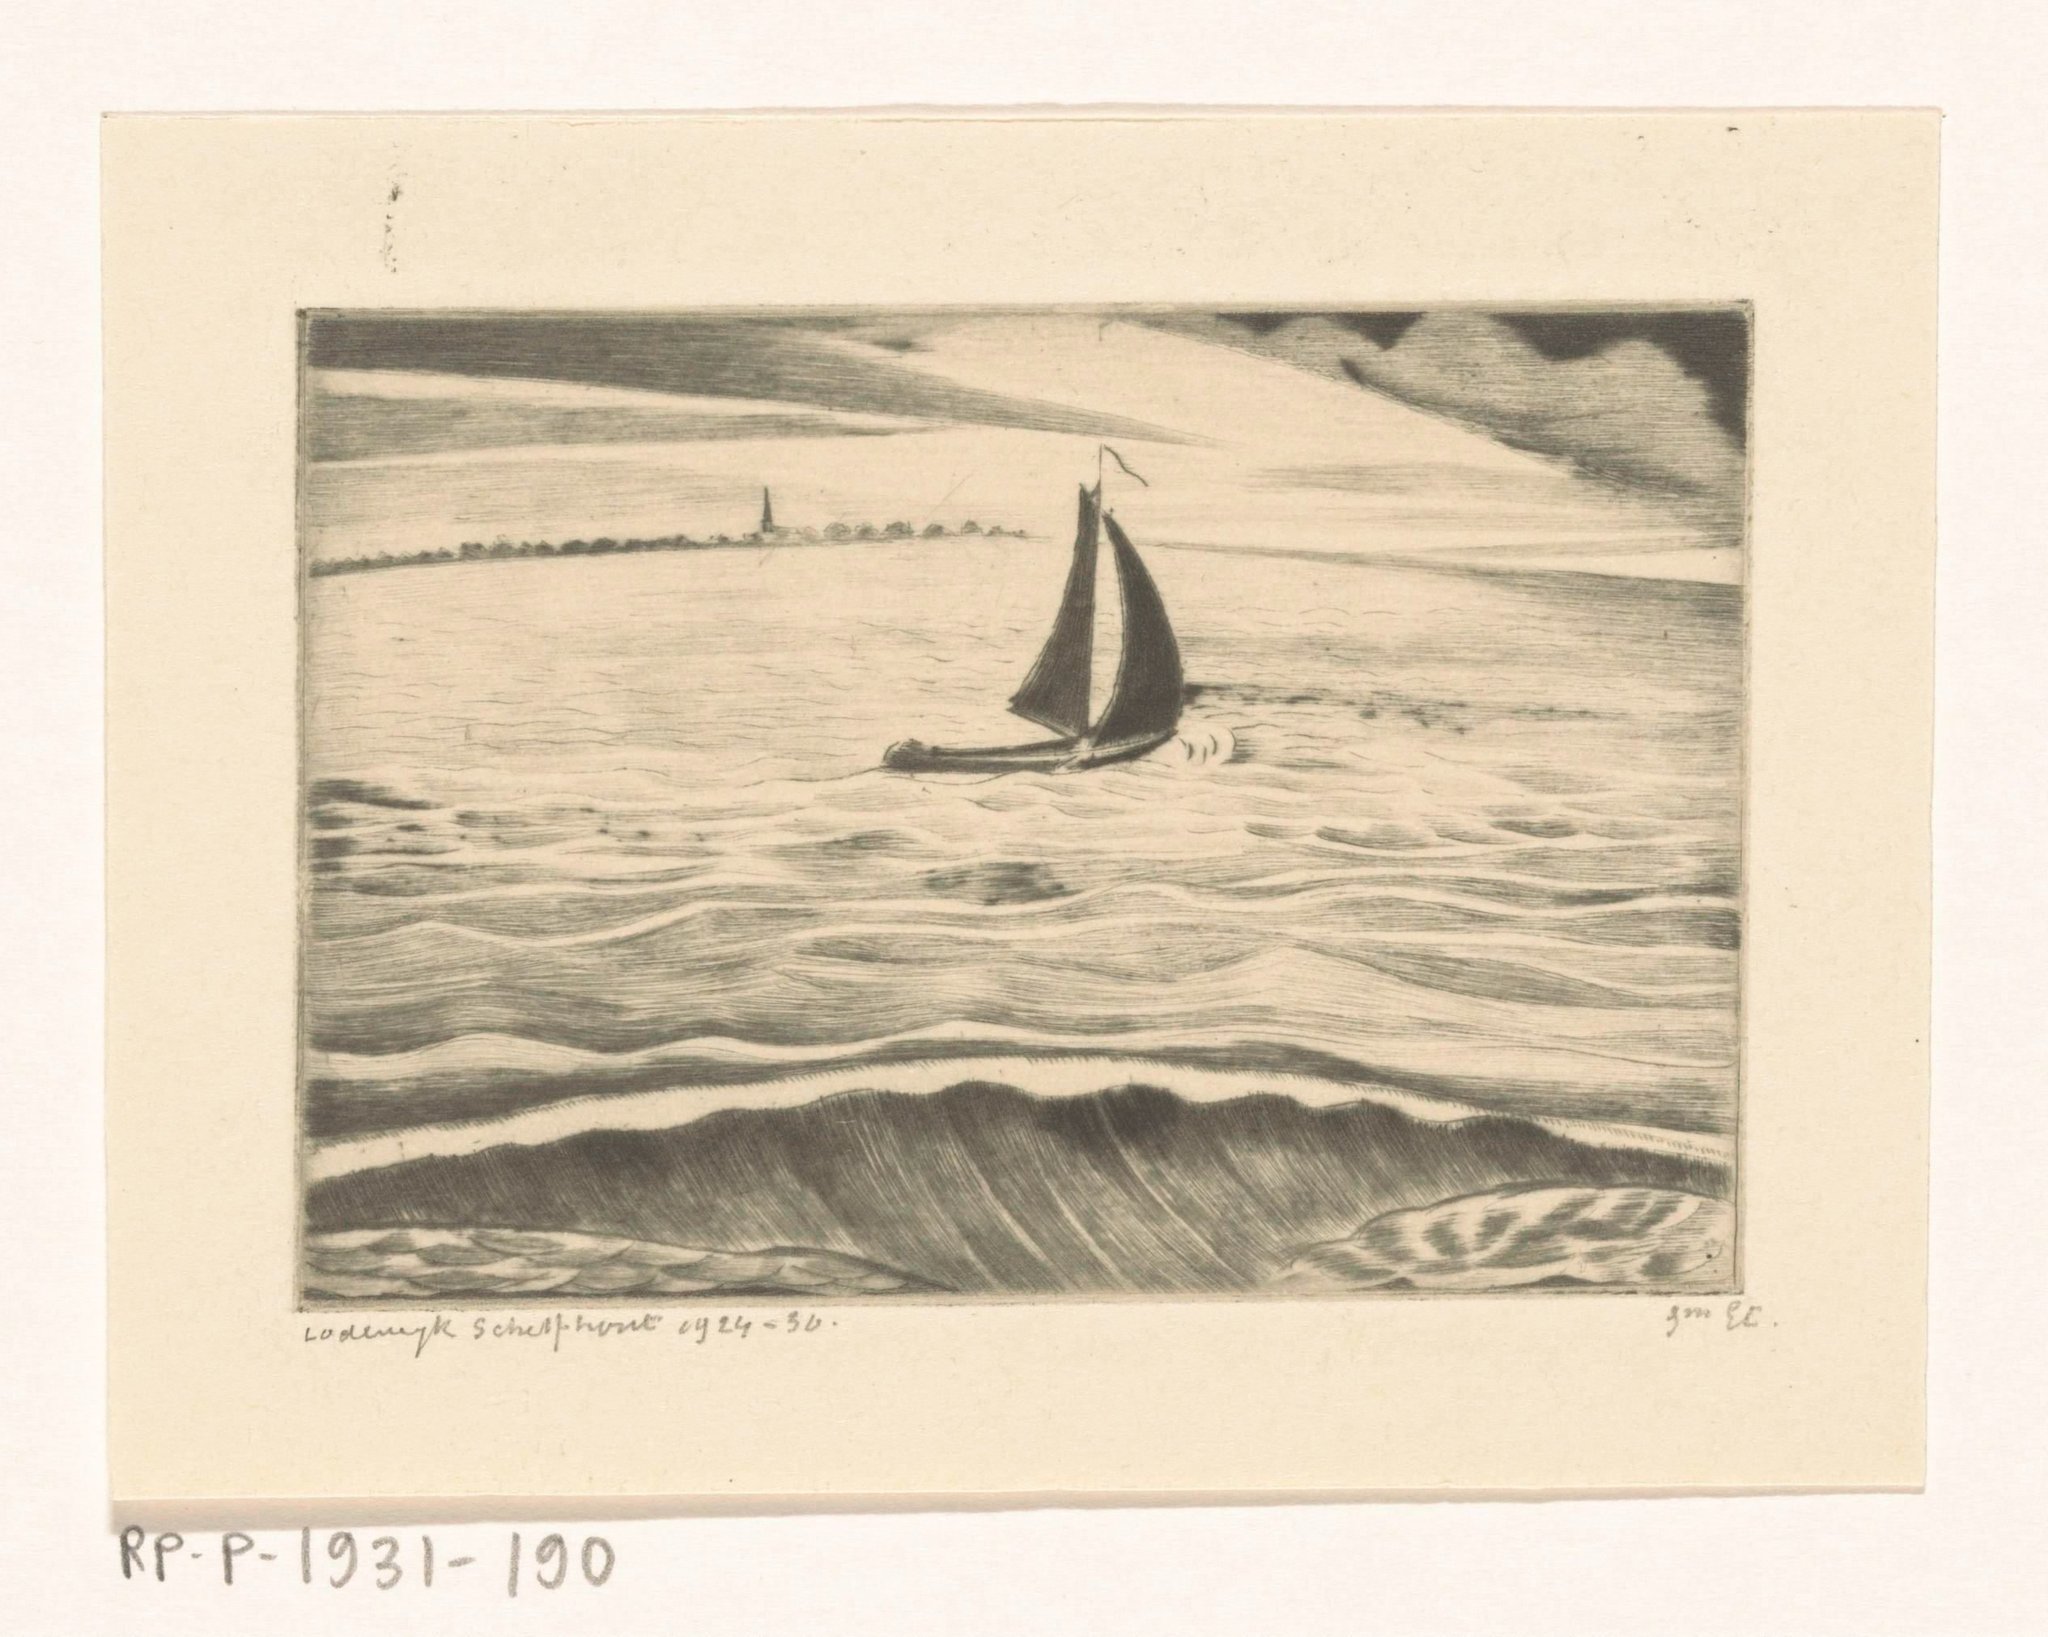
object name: print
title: Zeilschip bij Marken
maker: lodewijk schelfhout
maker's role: draughtsman, print maker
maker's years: 1881-1943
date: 1924-1930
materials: paper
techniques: drypoint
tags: sailing-ship, sailing-boat, sea, zuiderzee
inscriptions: collector's mark: Lugt 2228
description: Een zeilschip op de Zuiderzee bij het eiland Marken.